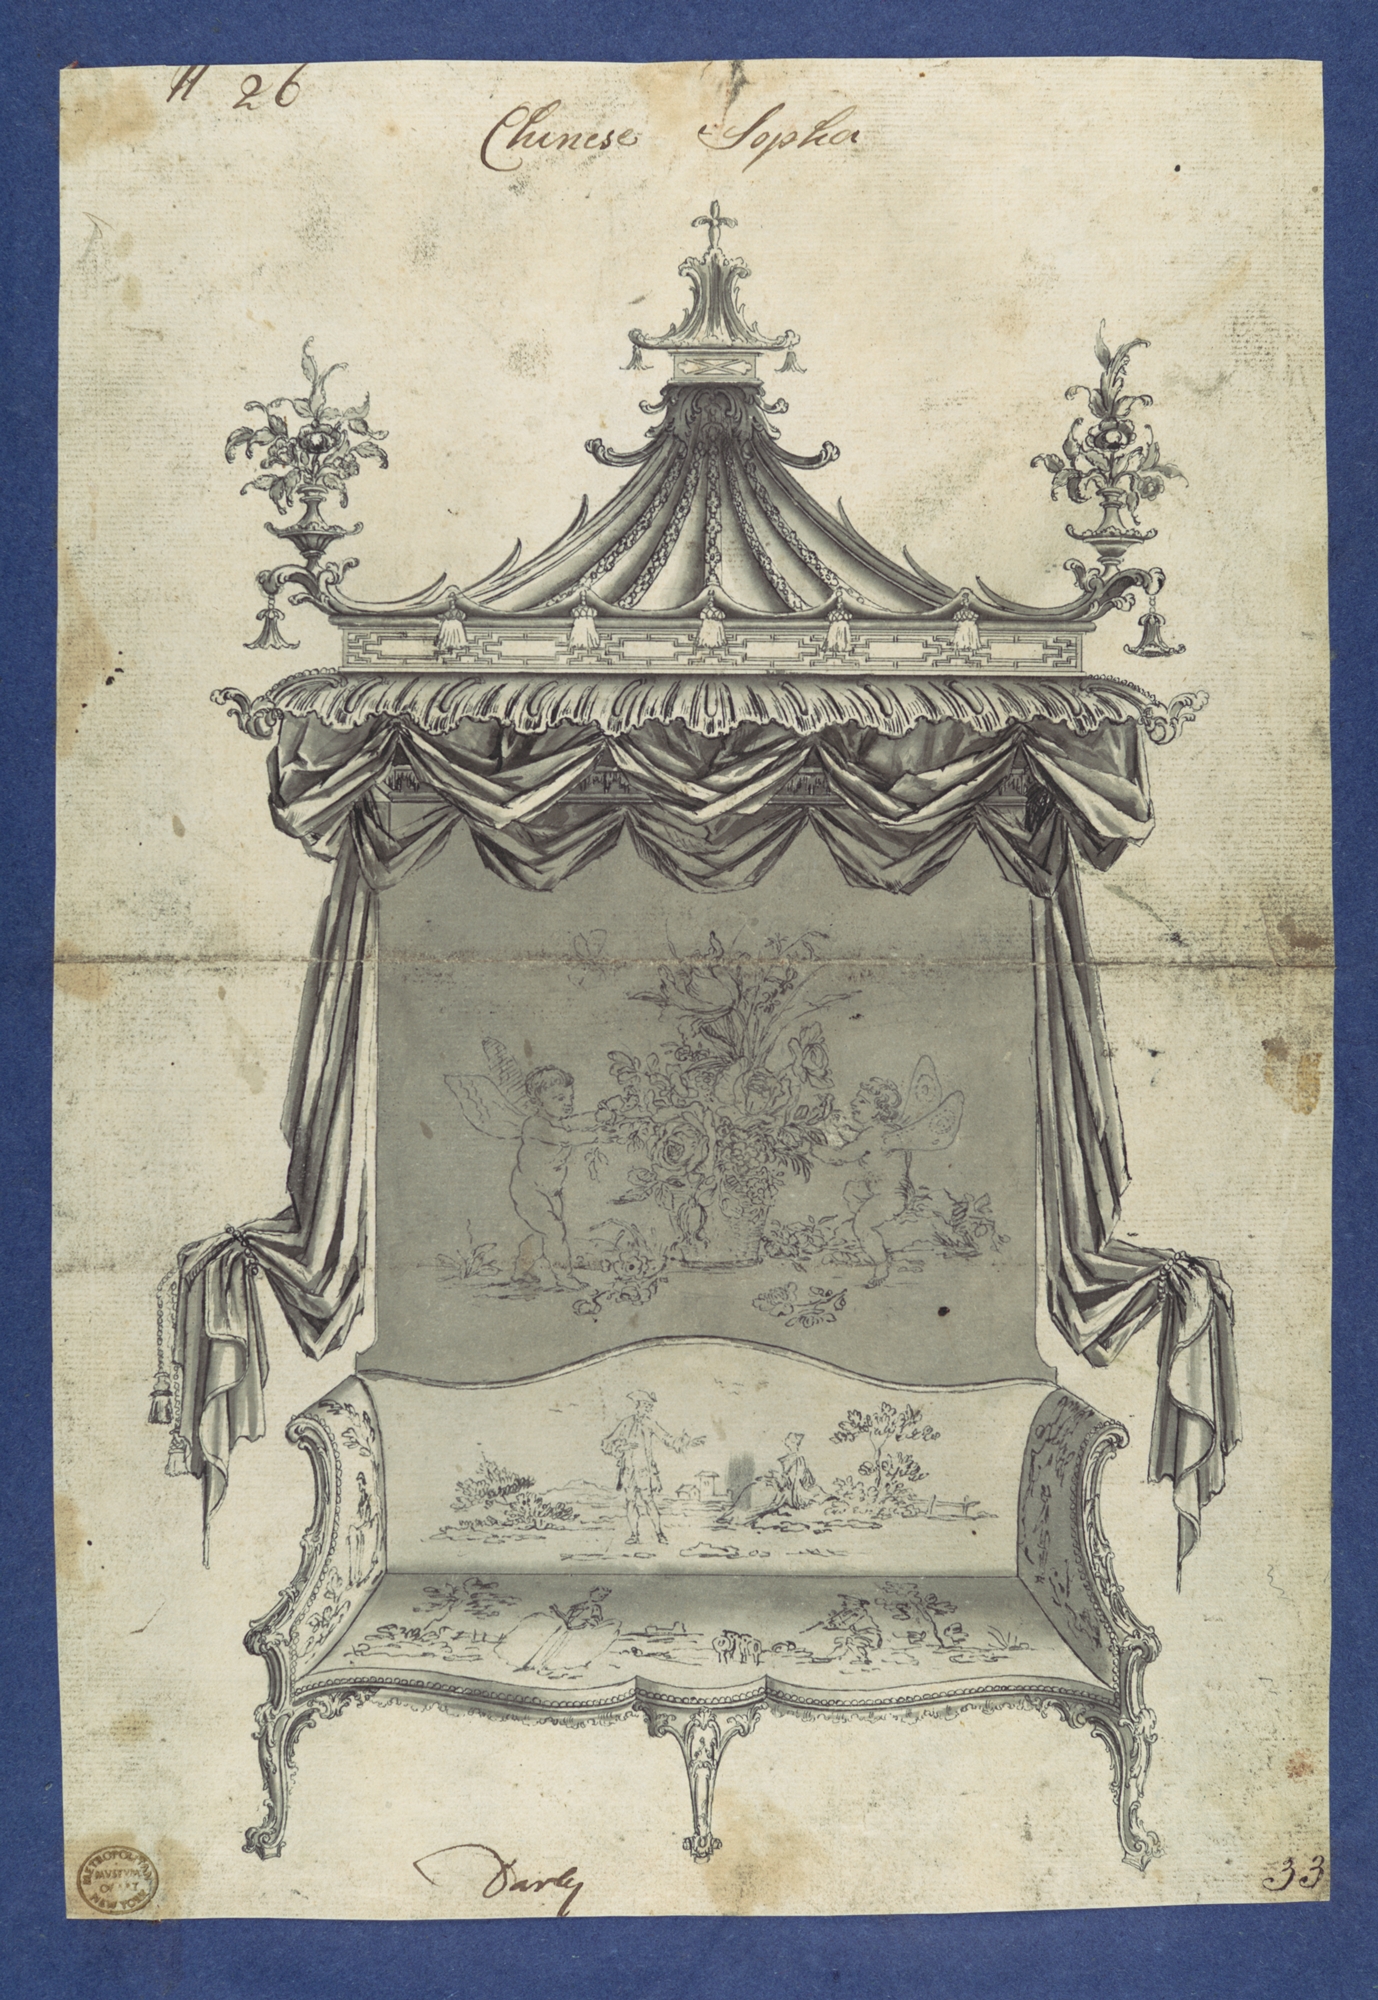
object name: drawing ornament architecture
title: Chinese Sopha [Sofa], in Chippendale Drawings, Vol. I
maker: thomas chippendale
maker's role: artist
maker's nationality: british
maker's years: 1718-1779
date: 1754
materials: ink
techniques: wash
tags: furniture